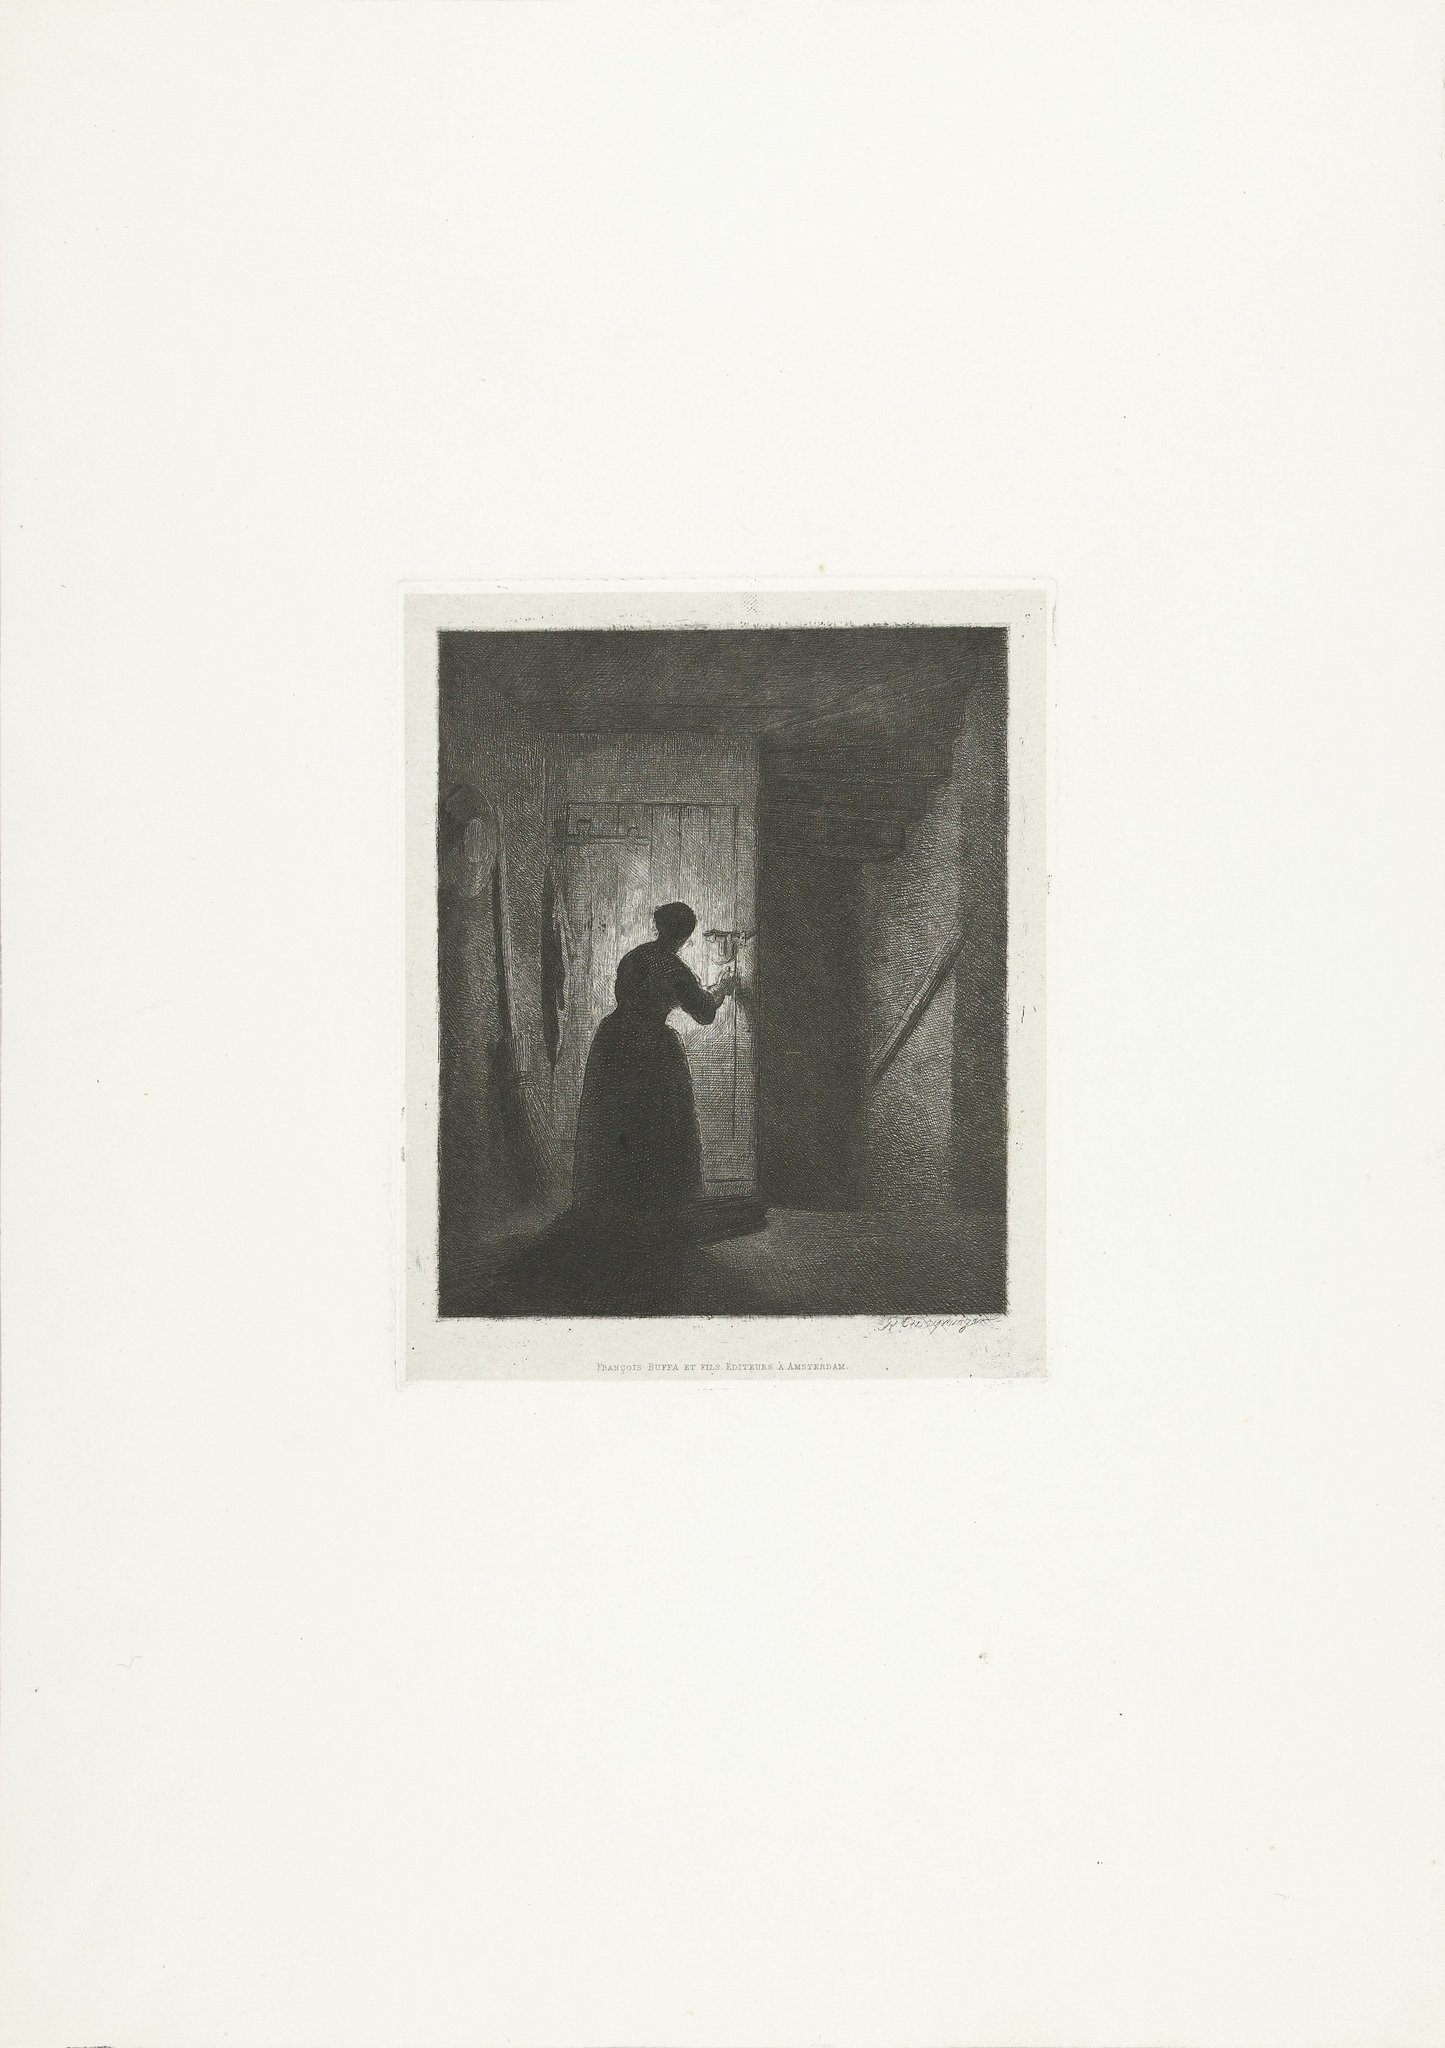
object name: print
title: Vrouw voor een deur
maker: reinier craeyvanger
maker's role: draughtsman, print maker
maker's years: 1812-1880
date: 1822-1880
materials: paper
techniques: etching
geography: amsterdam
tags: adult woman, opening the door, shrubs: broom, closed door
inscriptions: collector's mark: Lugt 2228, caption: ‘Francois Buffa et Fils, Éditeurs à Amsterdam’, collector's mark: Lugt 2166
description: Een vrouw staat voor een deur en draait aan de sleutel. Rechts een trap naar beneden. Links staat een veger tegen de muur. Een hoed en een jas hangen aan de muur.